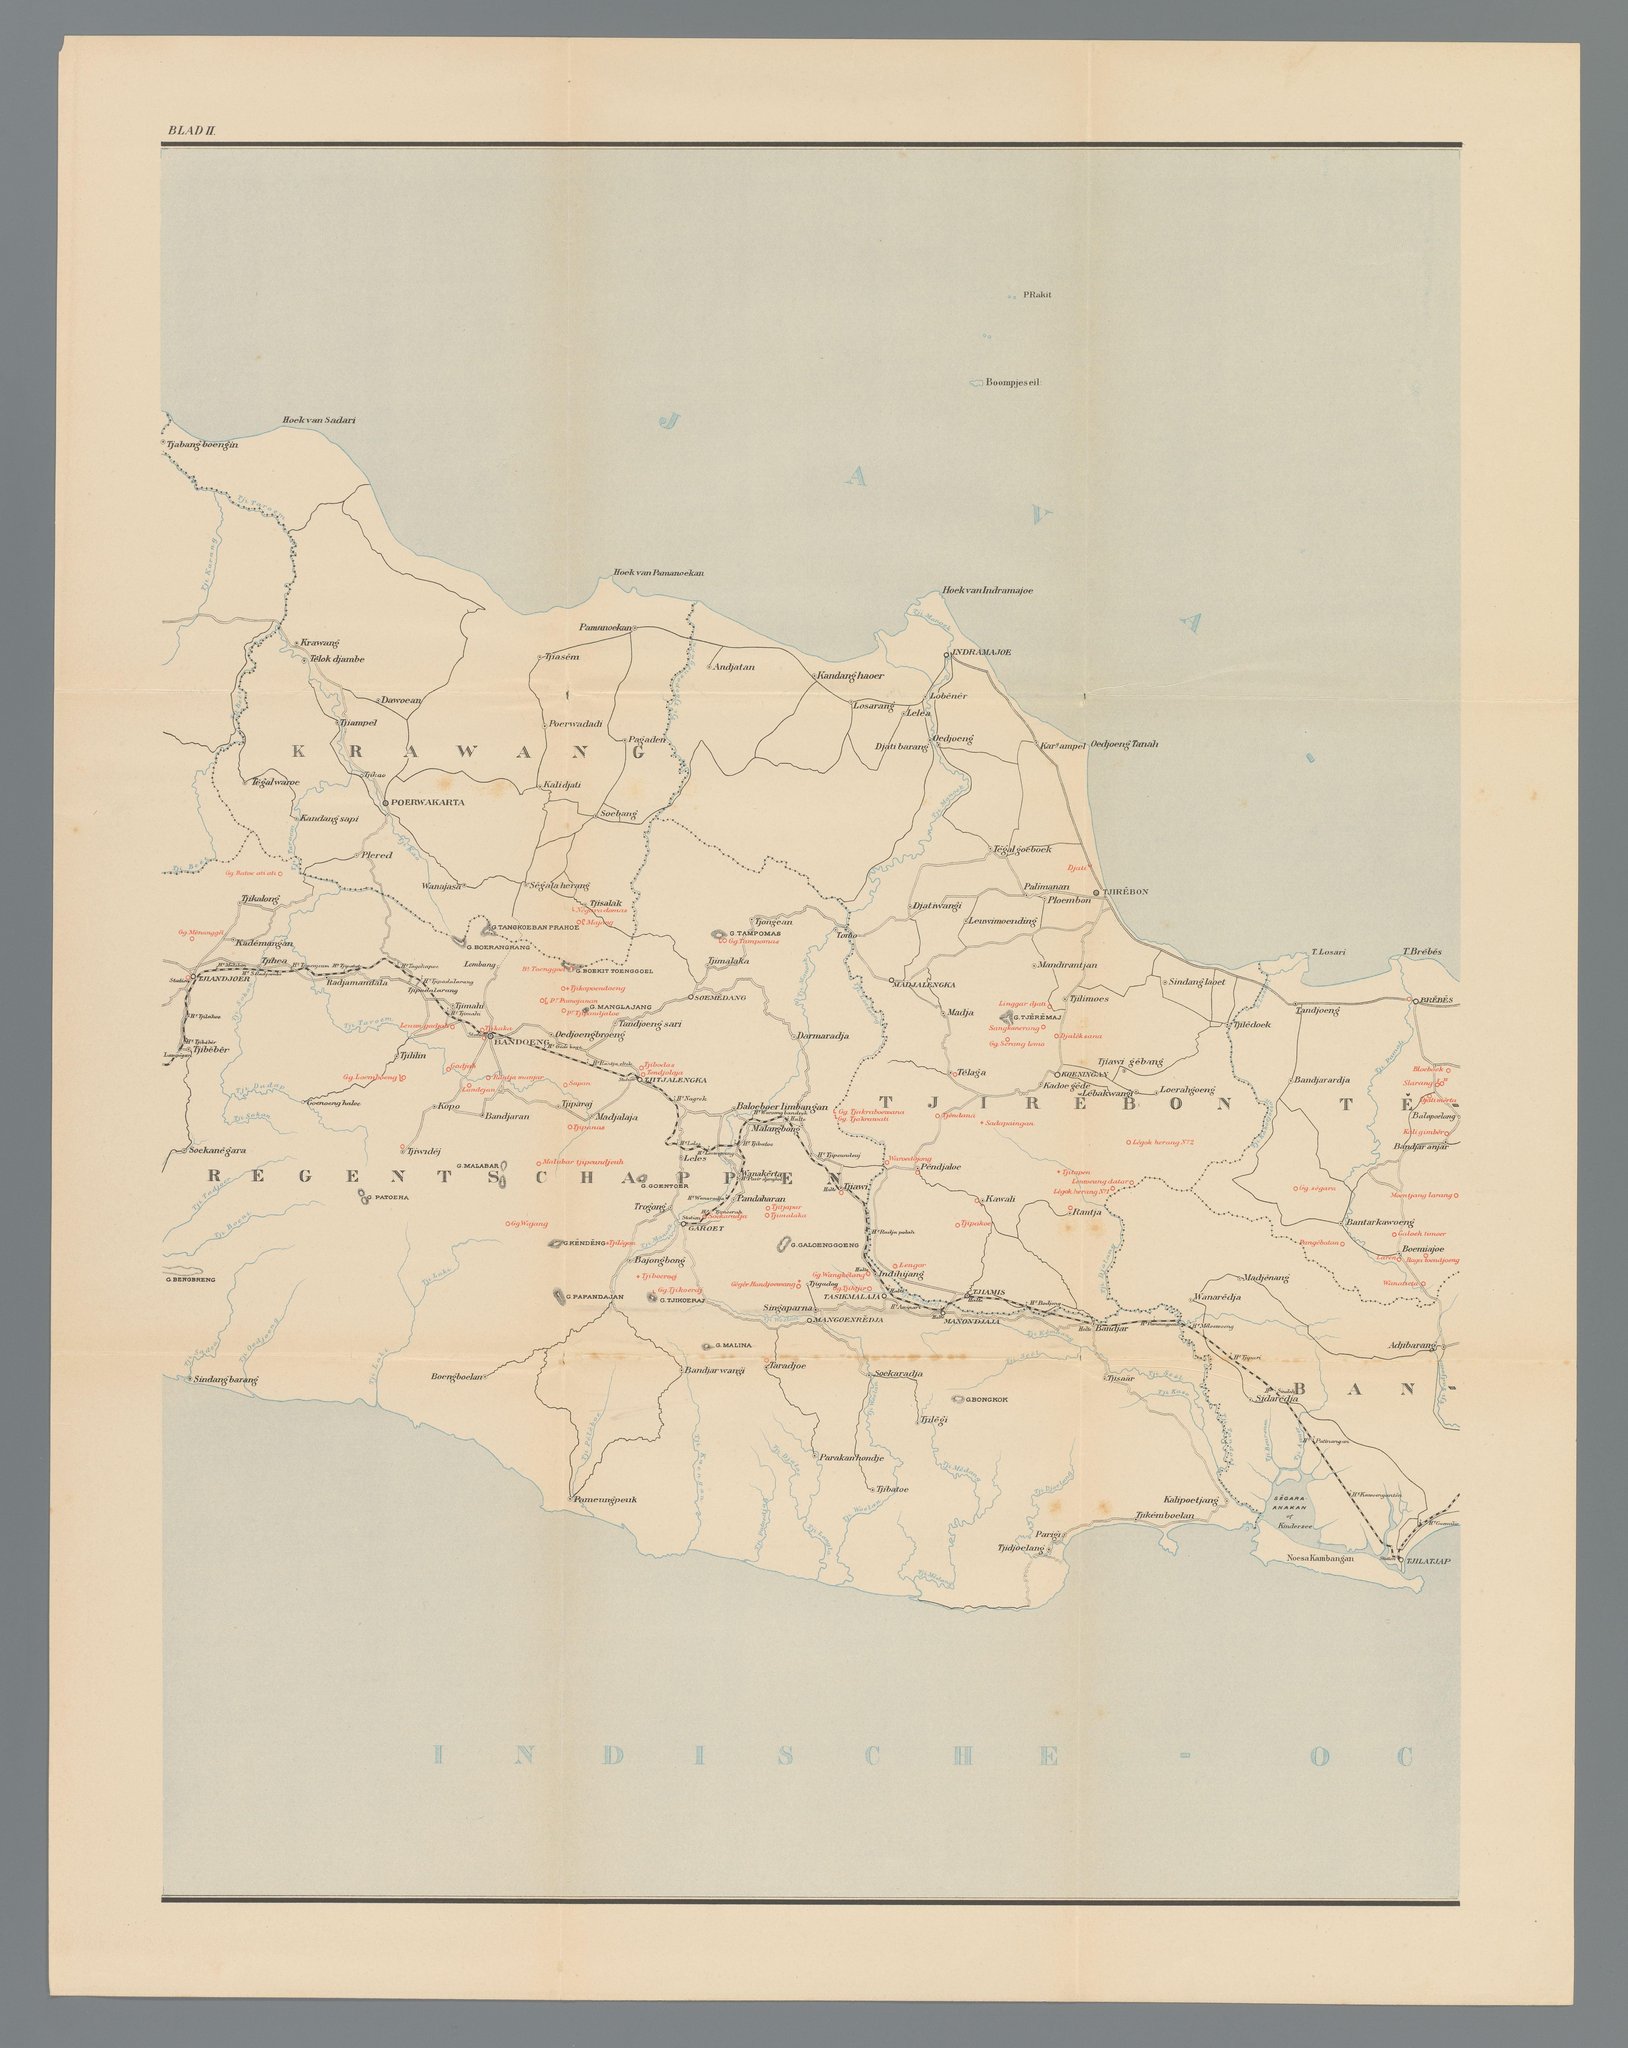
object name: map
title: Oudheidkundige kaart van West en midden Java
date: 1890-1891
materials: paper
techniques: lithograph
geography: the hague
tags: maps of separate countries or regions, java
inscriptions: collector's mark: ‘Bibliotheek Rijksmuseum Amsterdam’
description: Prent ook gebruikt in: Verhandelingen van het Bataafsch Genootschap (...). Den Haag: Martinus Nijhoff, dl. 46, 1891.